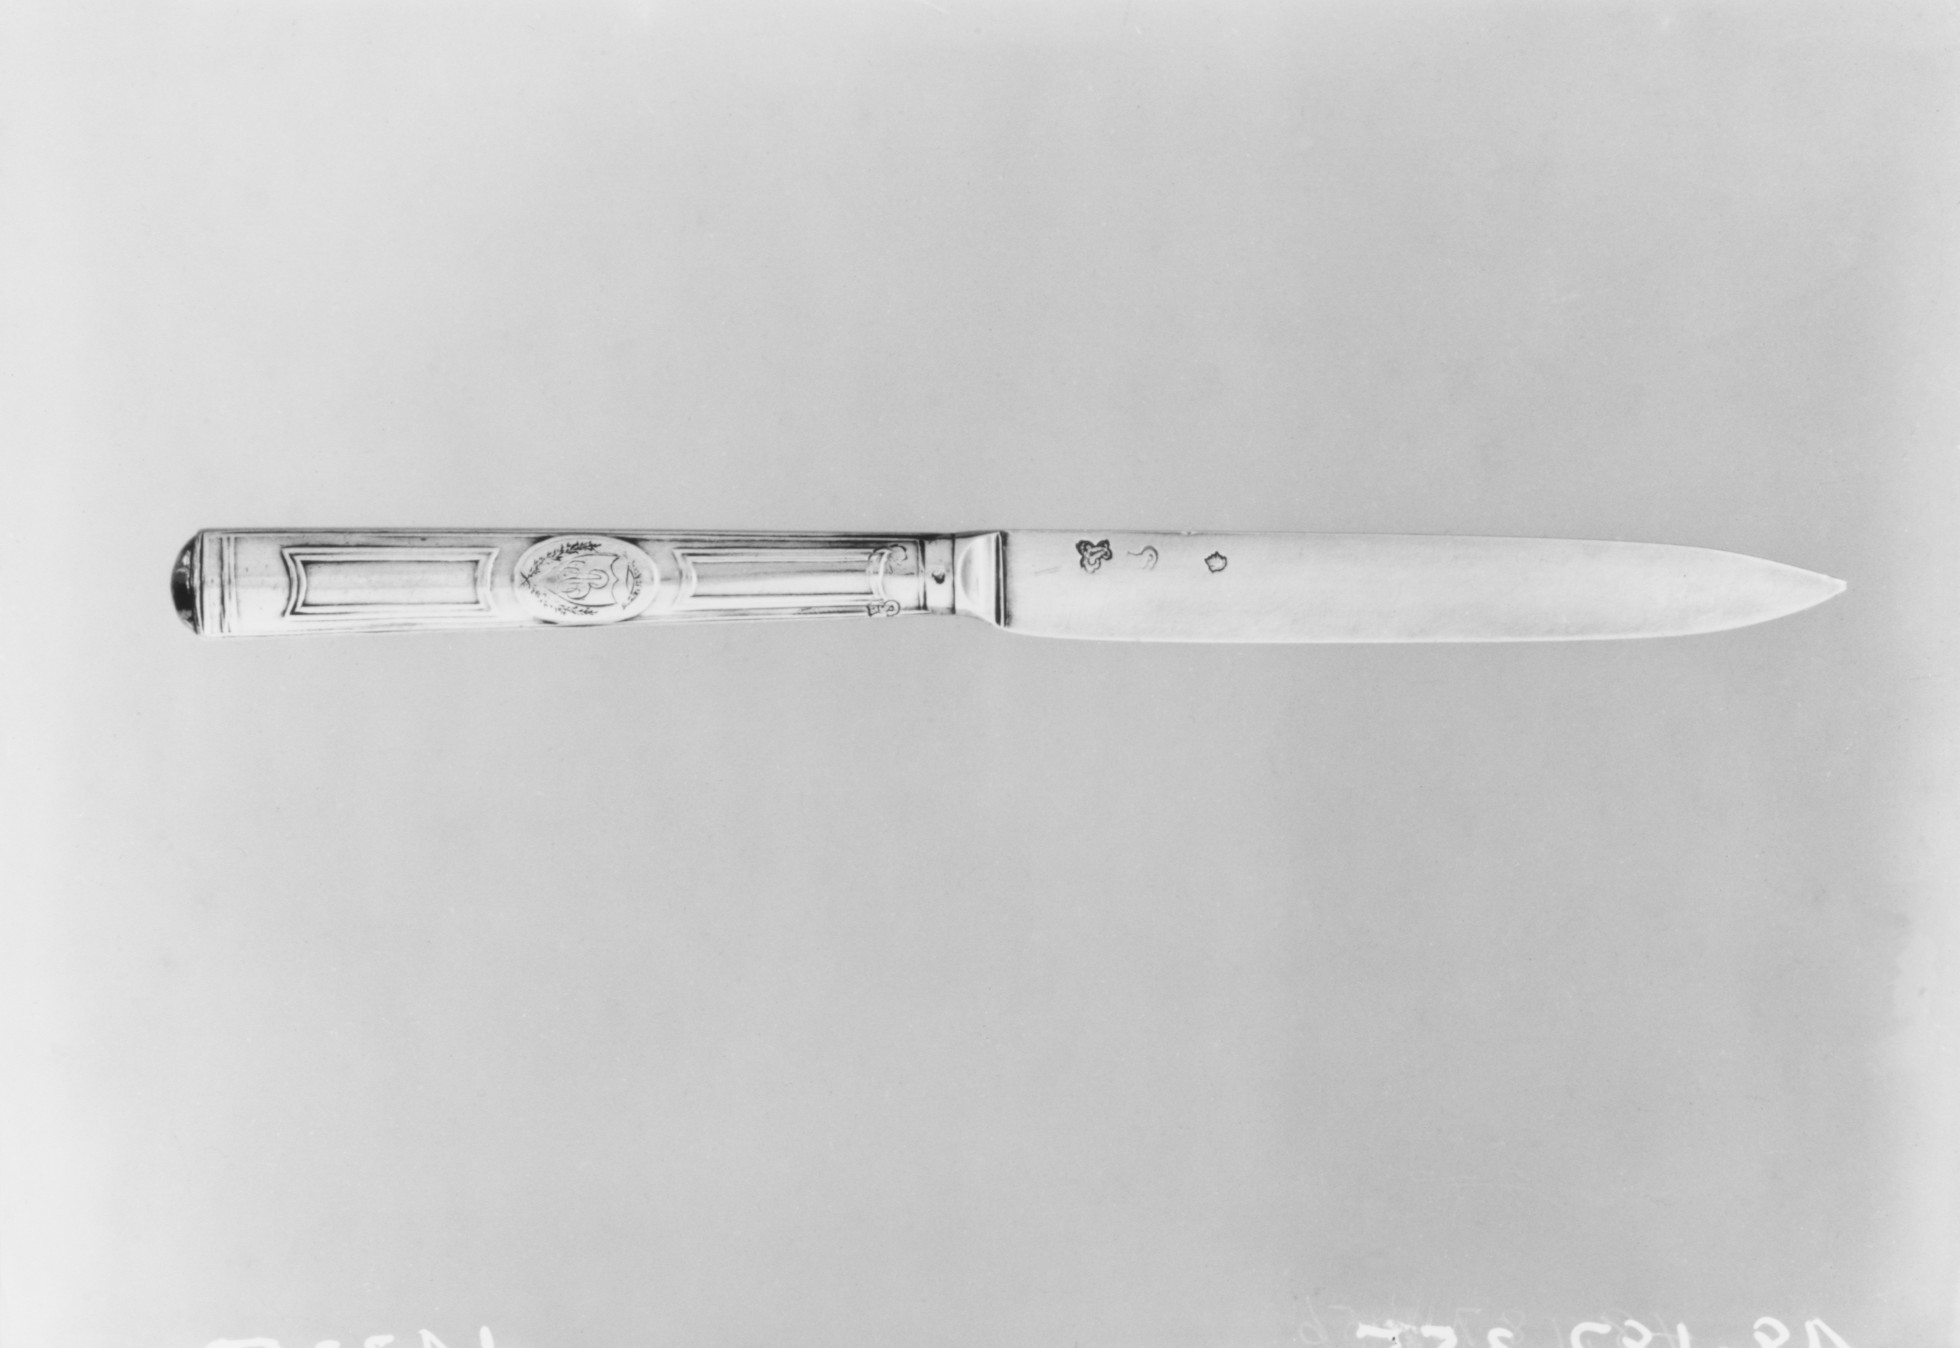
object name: knife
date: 1782-1783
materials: silver